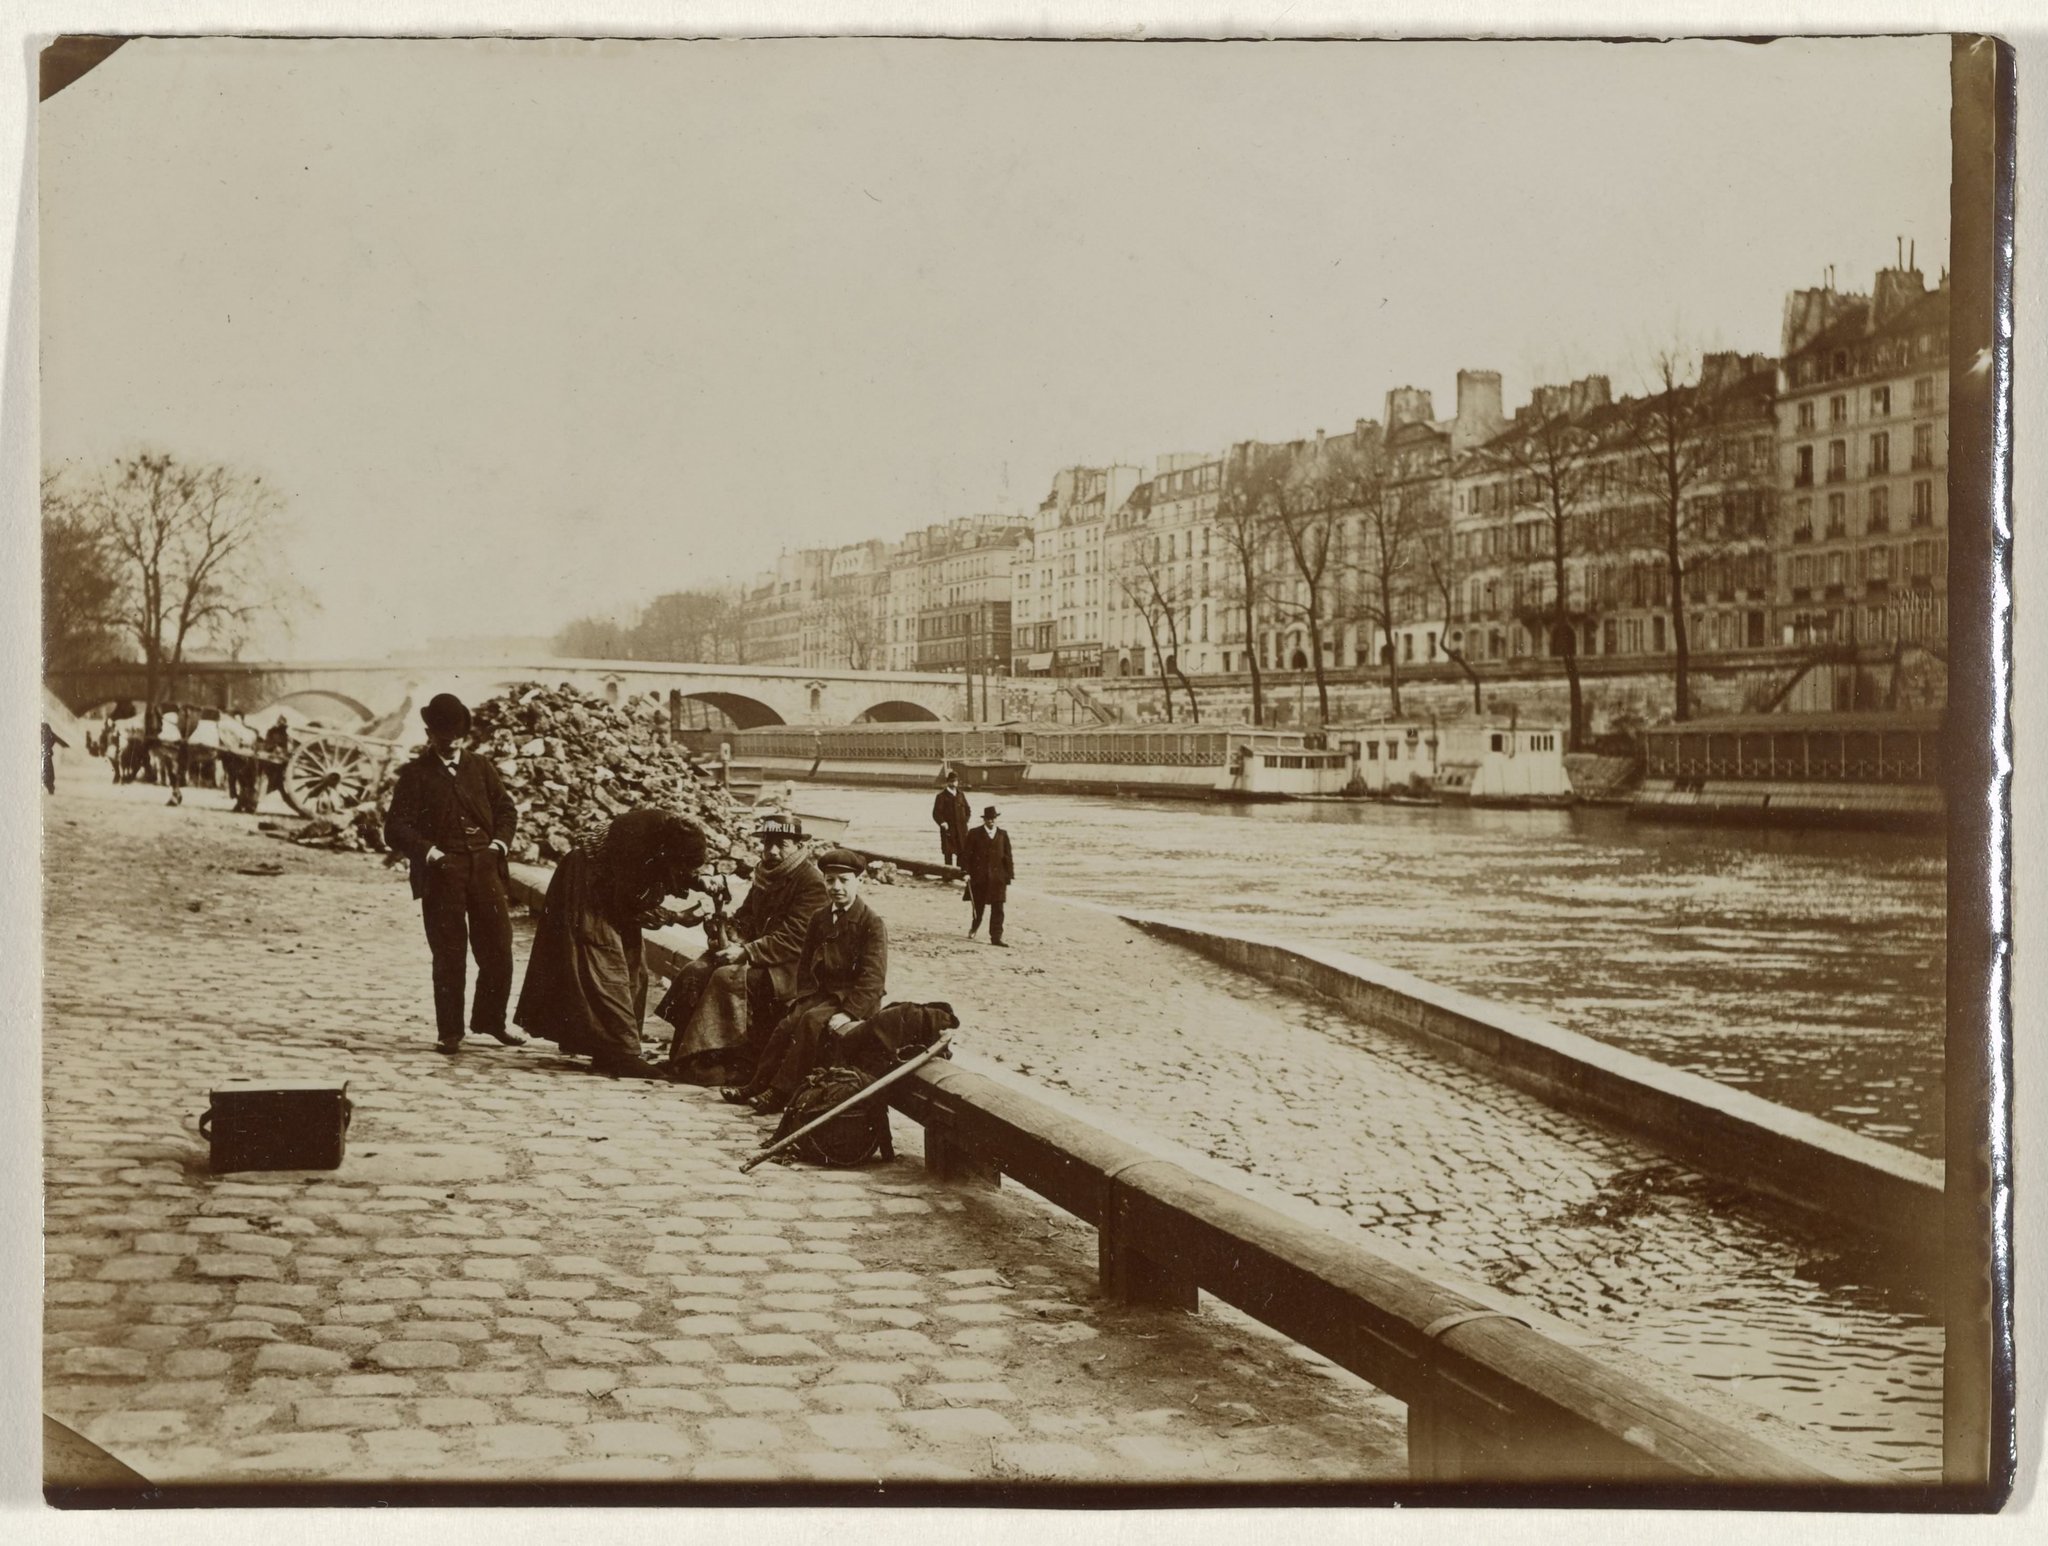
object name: photograph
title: Hondenkapper op de kade van de Seine in Parijs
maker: Anonymous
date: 1900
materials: paper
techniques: gelatin silver print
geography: paris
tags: quay, paris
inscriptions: inscription: ‘Tondeurs de chiens/ Beryes de la Seine’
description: Op de pet van de man is Tondeur te lezen.